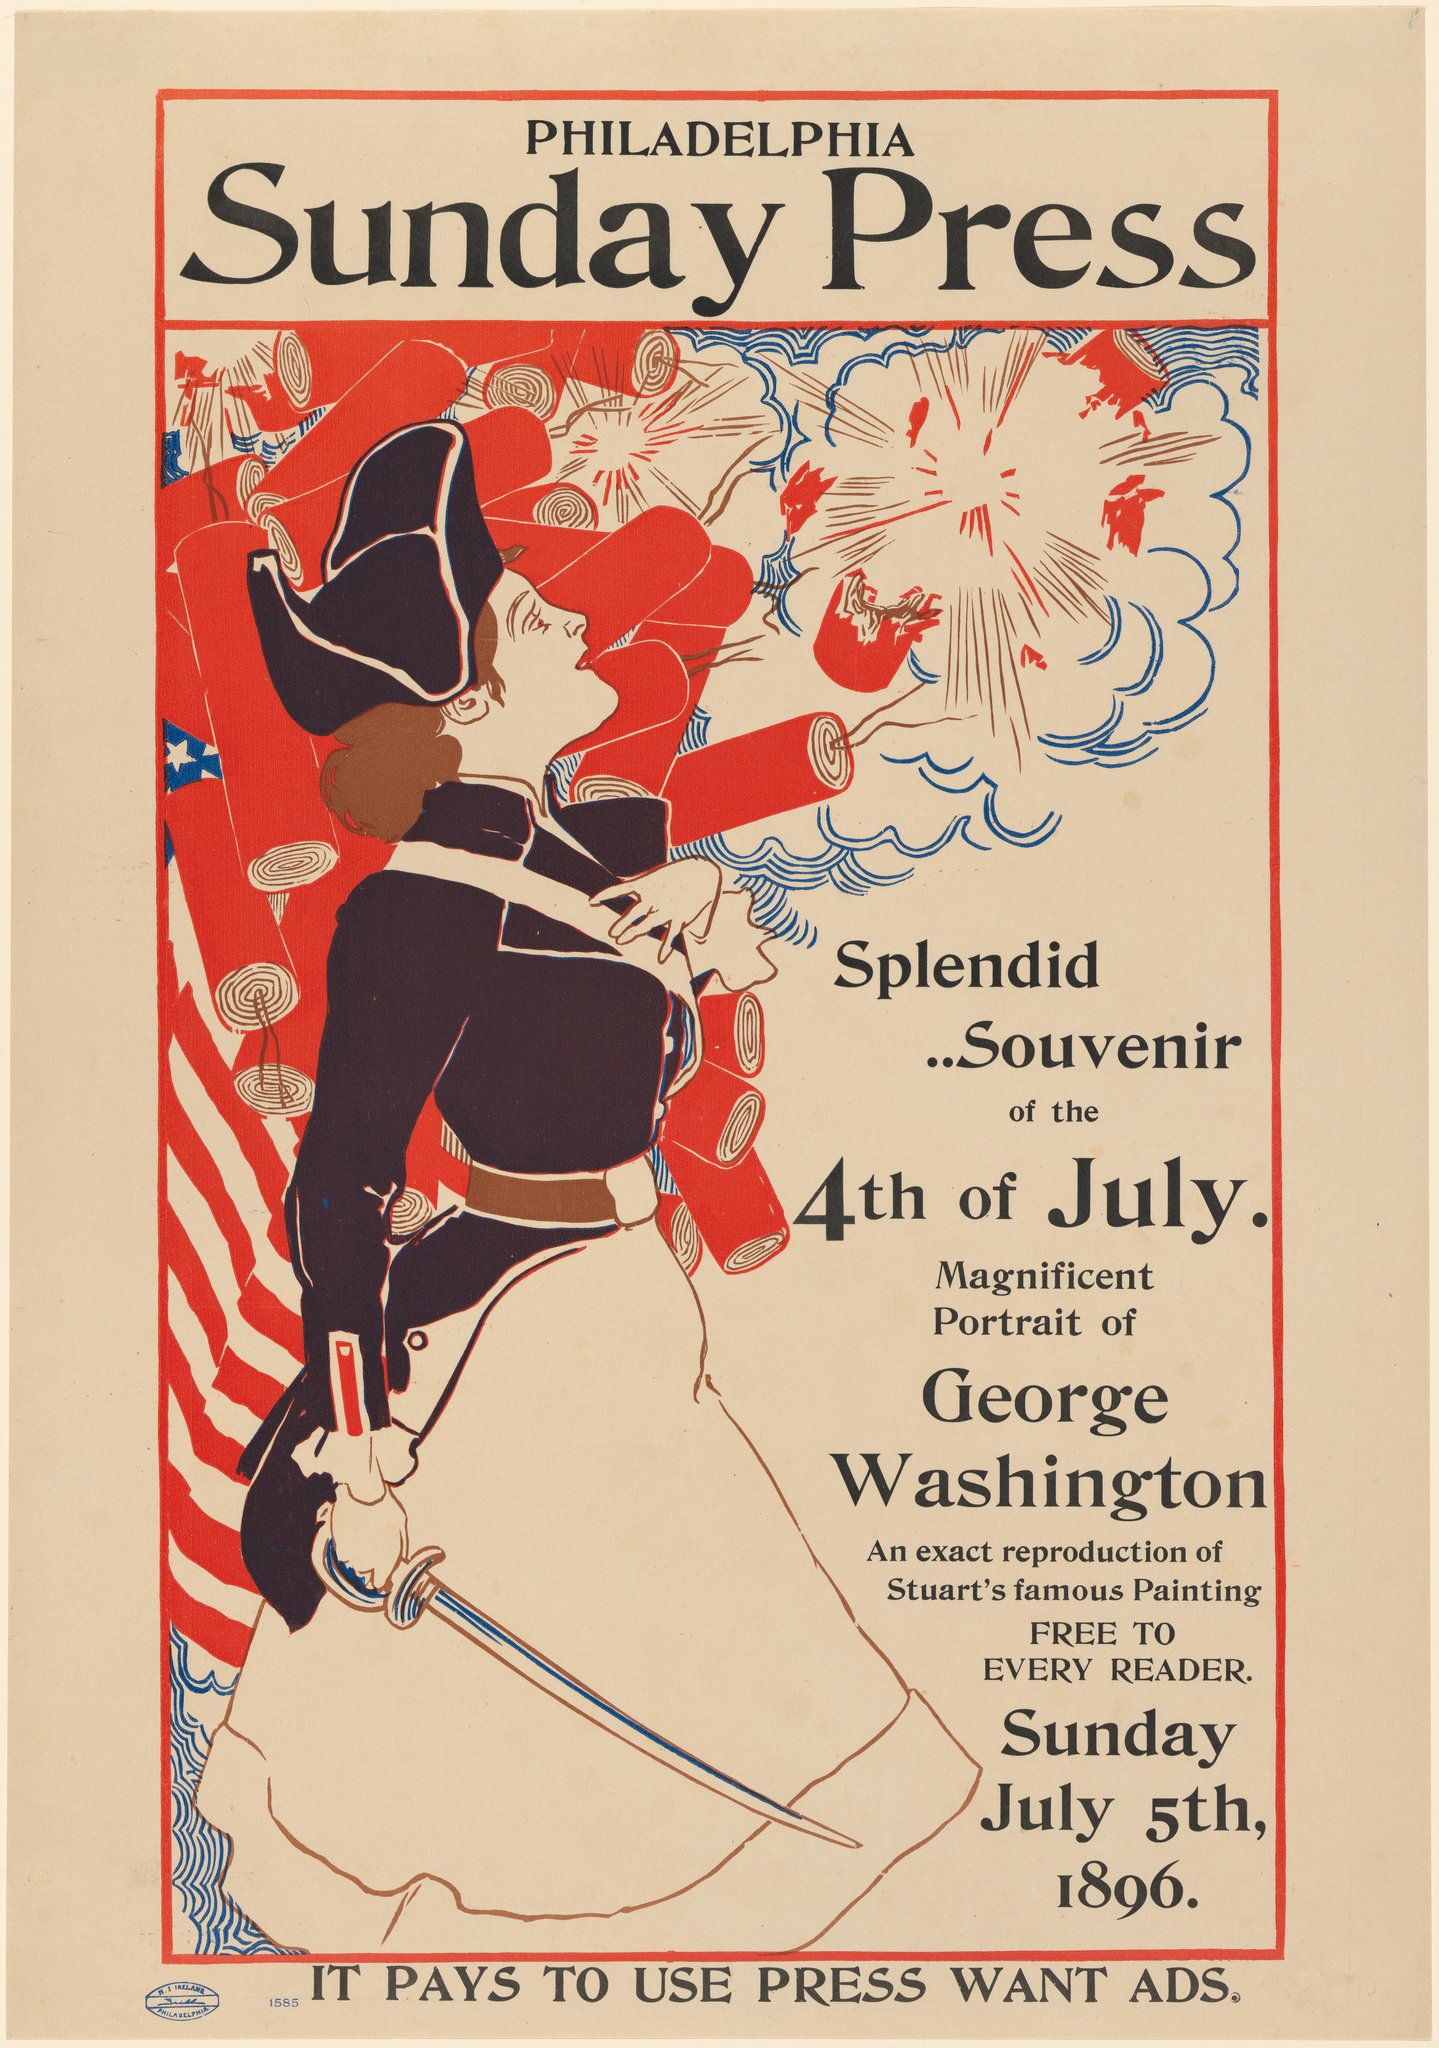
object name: print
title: Philadelphia Sunday Press, July 5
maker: george reiter brill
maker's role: artist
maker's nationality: american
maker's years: 1867-1918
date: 1896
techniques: lithograph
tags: women,fireworks